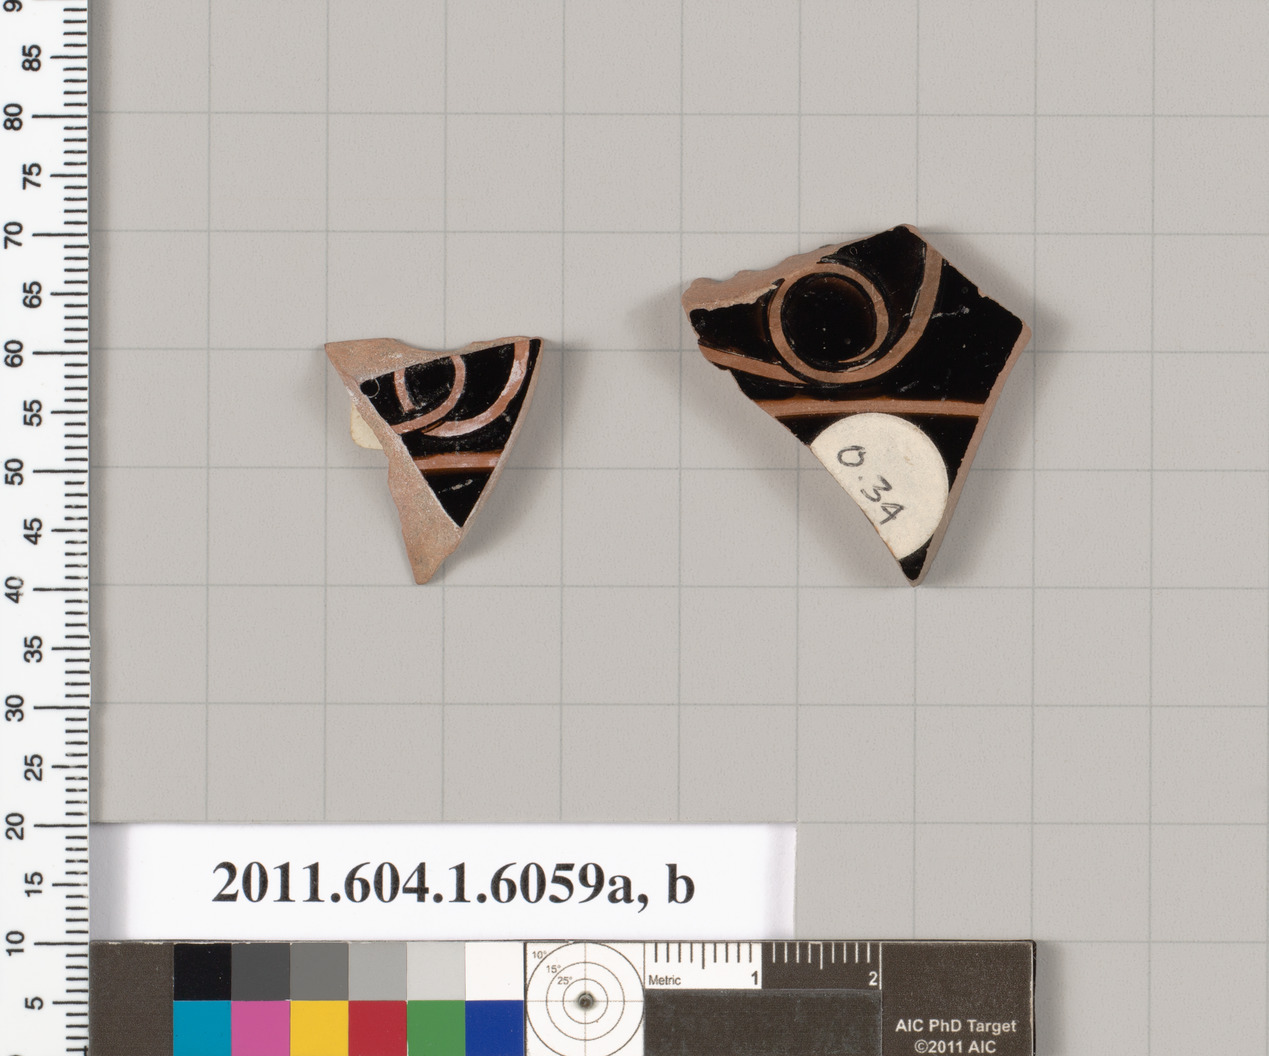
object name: kylix fragment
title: Terracotta fragments of kylikes (drinking cups)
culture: greek, attic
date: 510-500 BCE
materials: terracotta